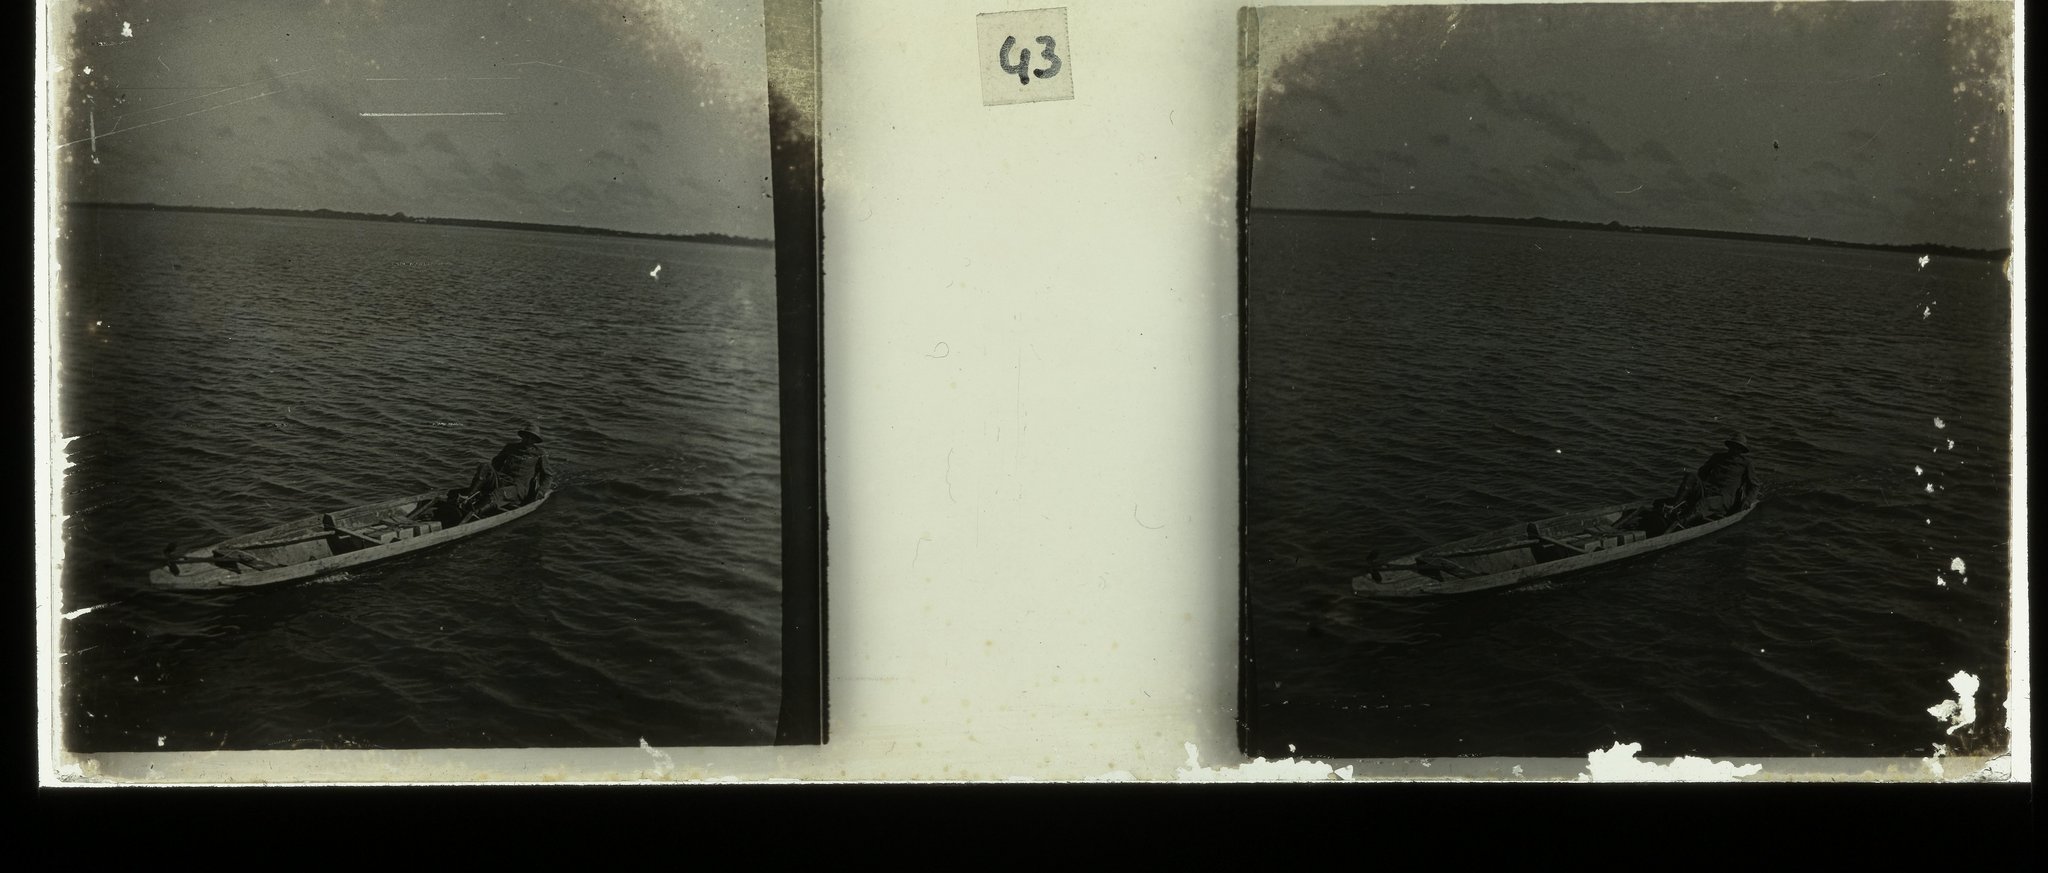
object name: stereograph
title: Theodoor Brouwers op de Surinamerivier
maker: Anonymous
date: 1913-1930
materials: glass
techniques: photography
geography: suriname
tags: amsterdam, theodoor brouwers, suriname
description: In de periode 1911-1932 woonde op plantage Accaribo in Suriname de familie Brouwers van wie de foto's afkomstig zijn. Rond 1910 vond Theodoor Brouwers werk op plantage Accaribo. In 1929 werd hij eigenaar van de plantage. Op Accaribo werden in zijn tijd bananen geproduceerd en wat koffie.